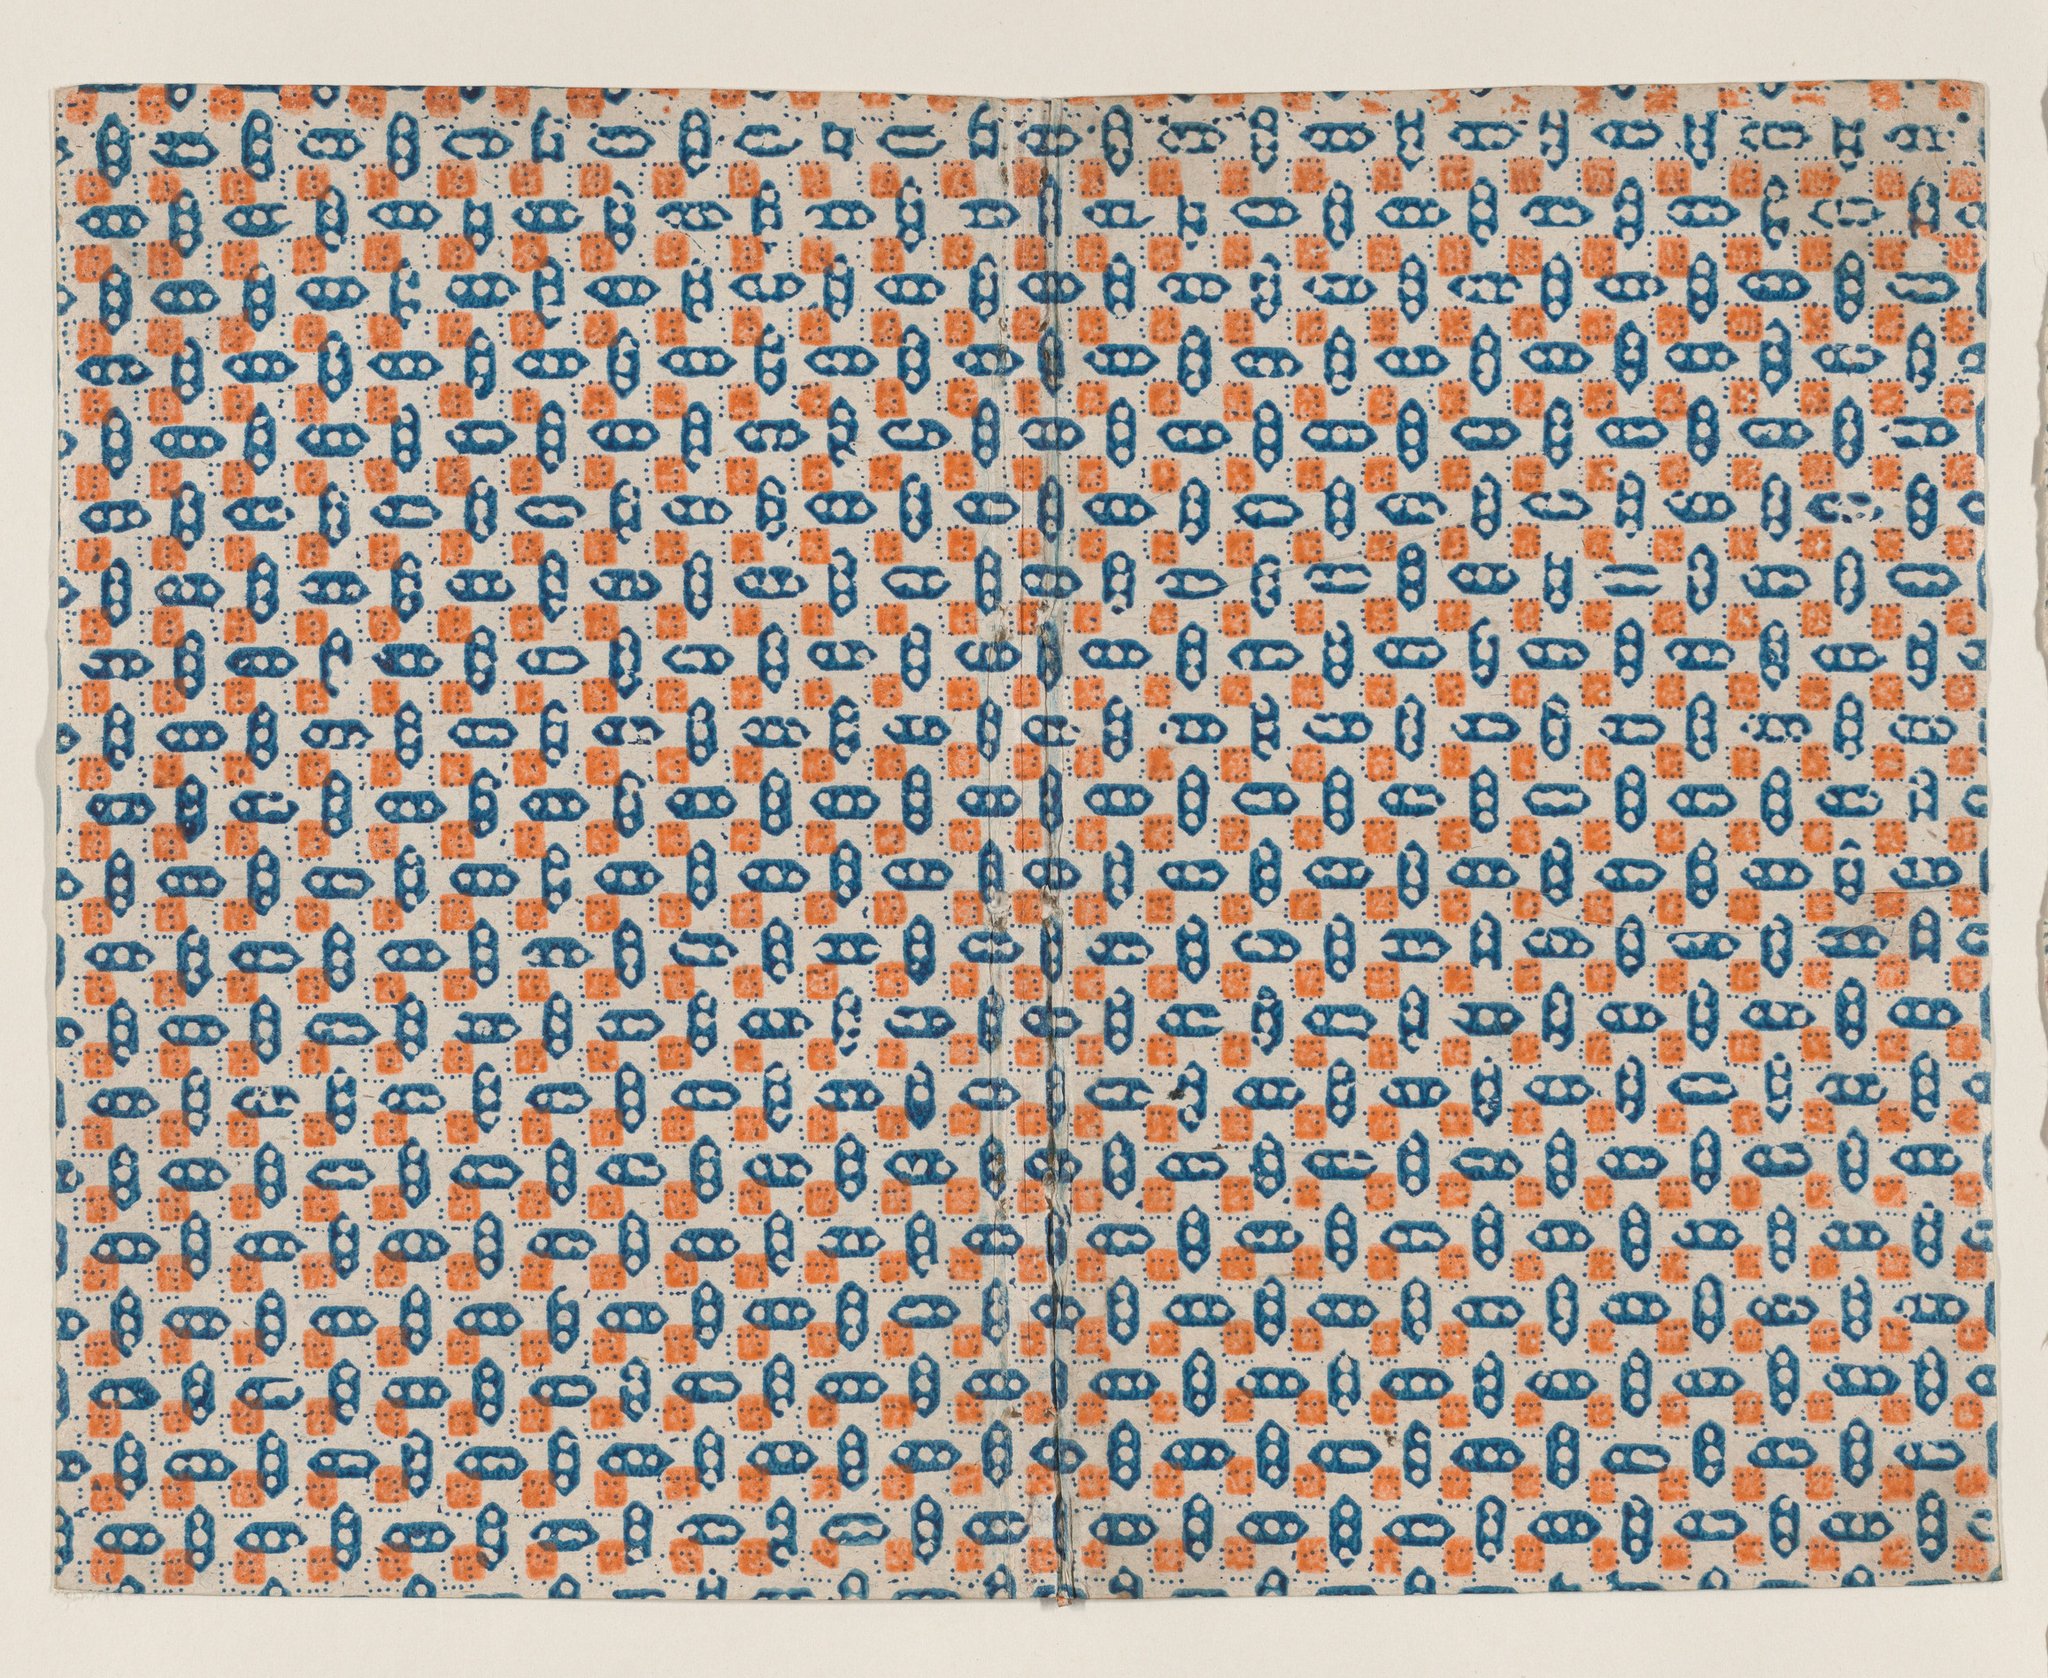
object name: print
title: Book cover with overall geometric pattern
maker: Anonymous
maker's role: artist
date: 1801-1900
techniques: relief print